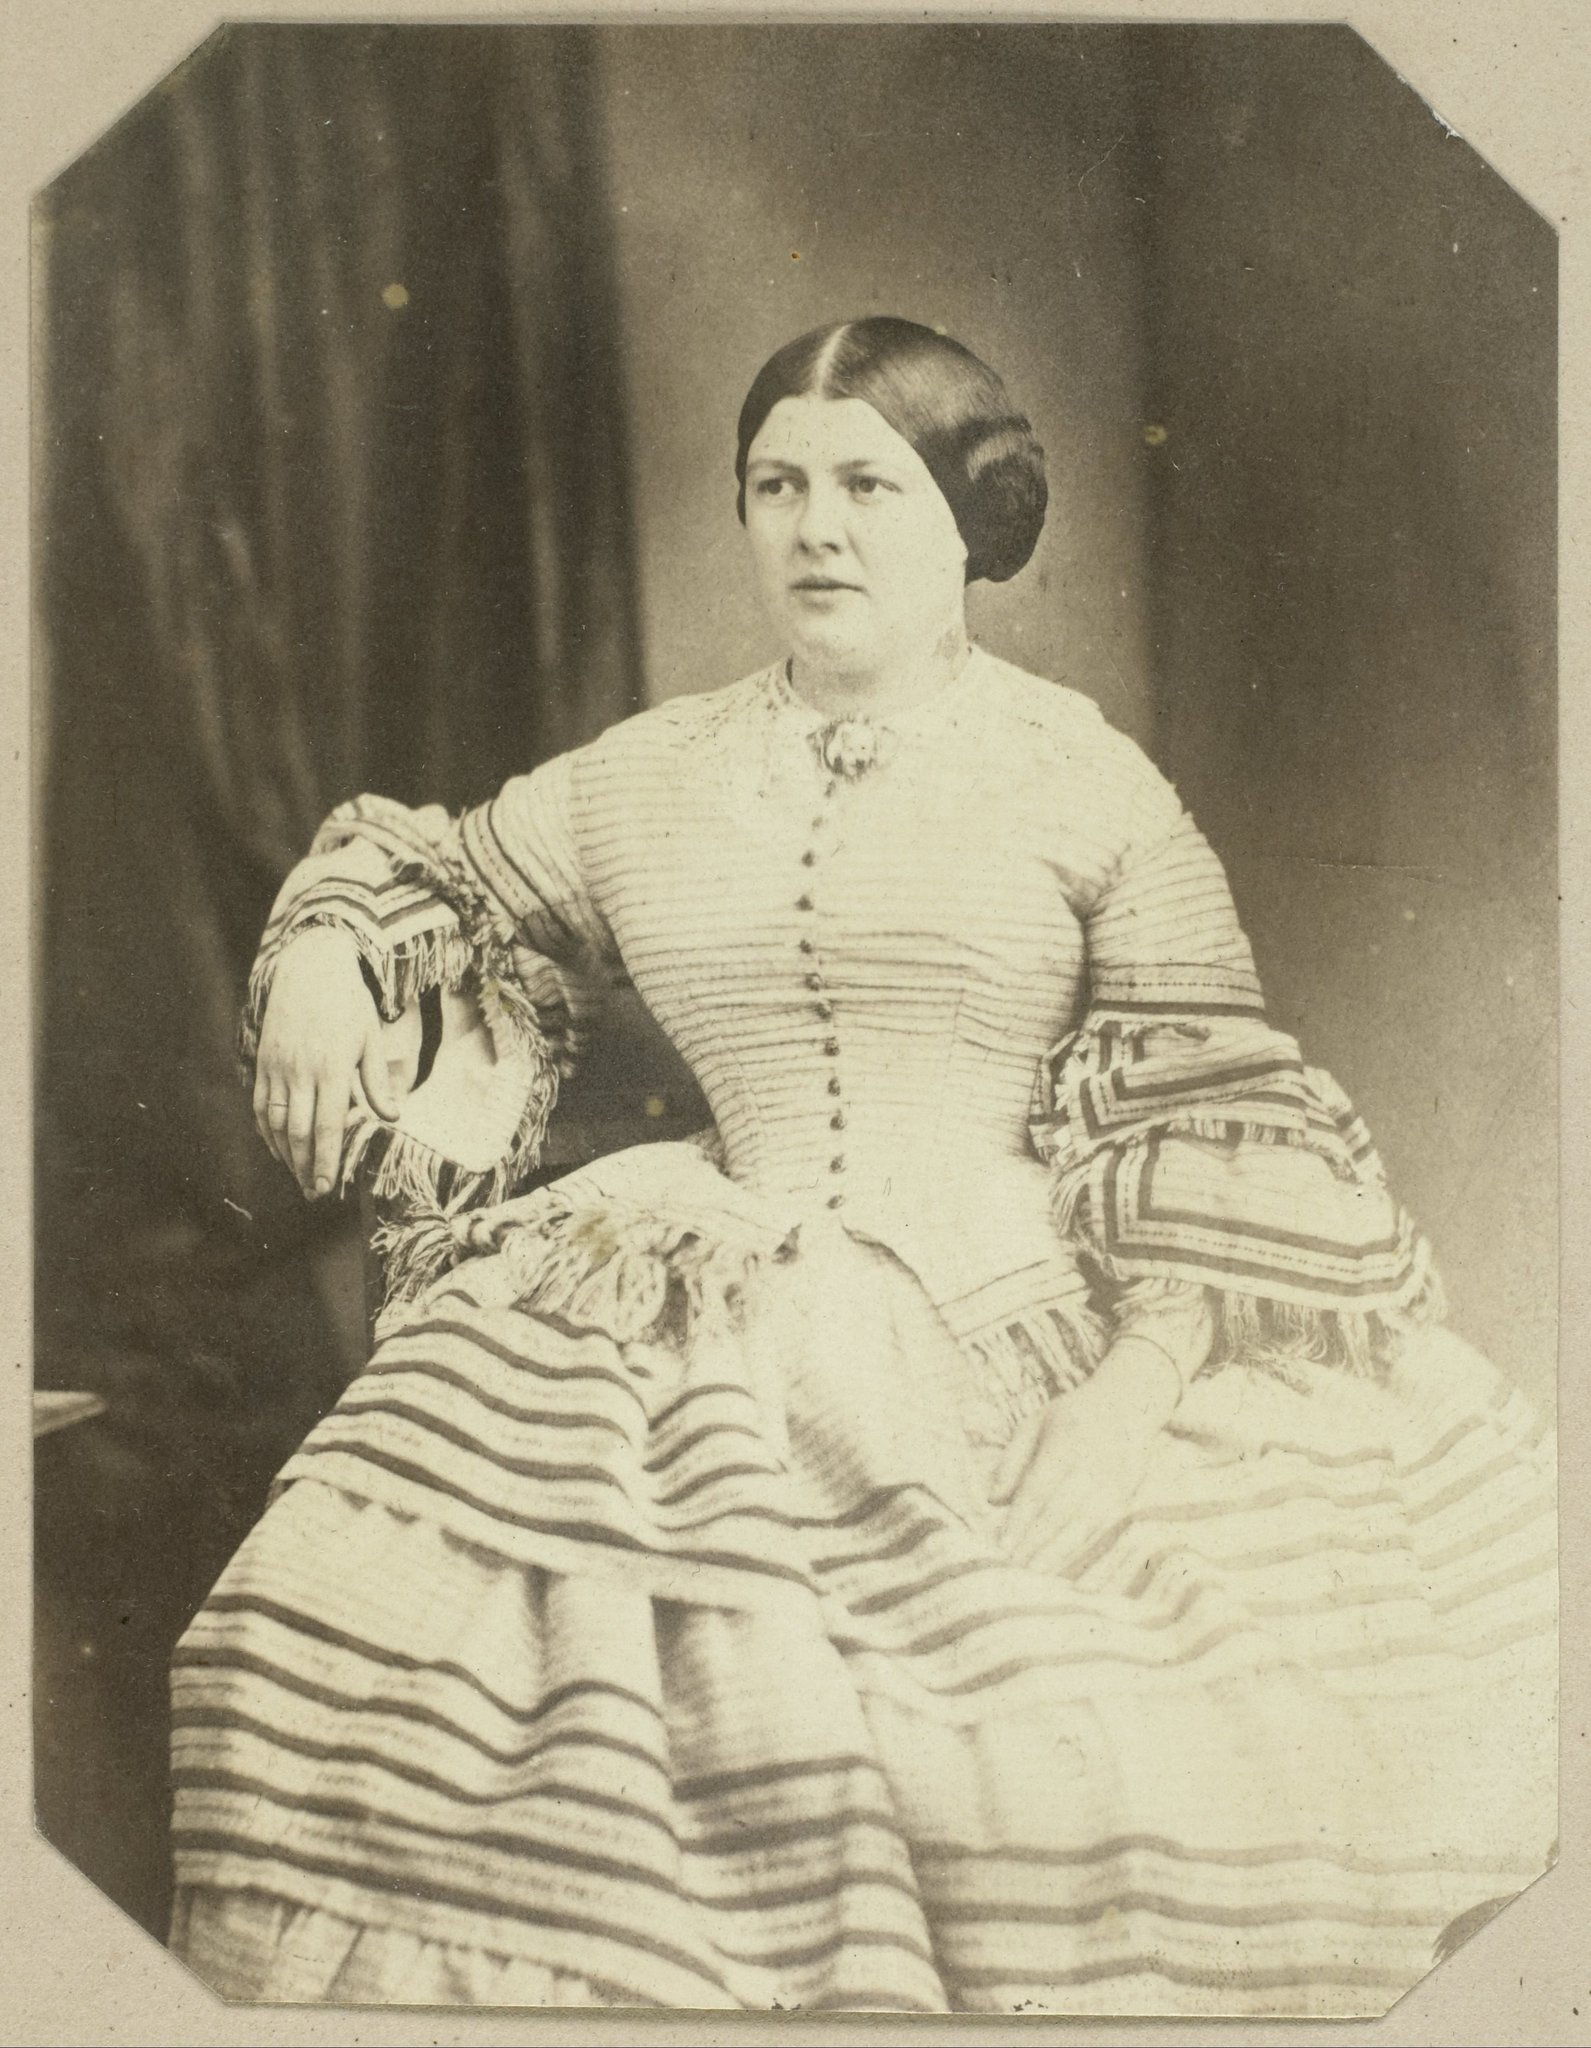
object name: photograph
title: Portret van een vrouw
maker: eduard isaac asser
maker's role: amateurfotograaf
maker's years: 1809-1894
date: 1854-1855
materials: cardboard, paper, photographic support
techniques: salted paper print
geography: amsterdam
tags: historical persons - bb - woman, netherlands